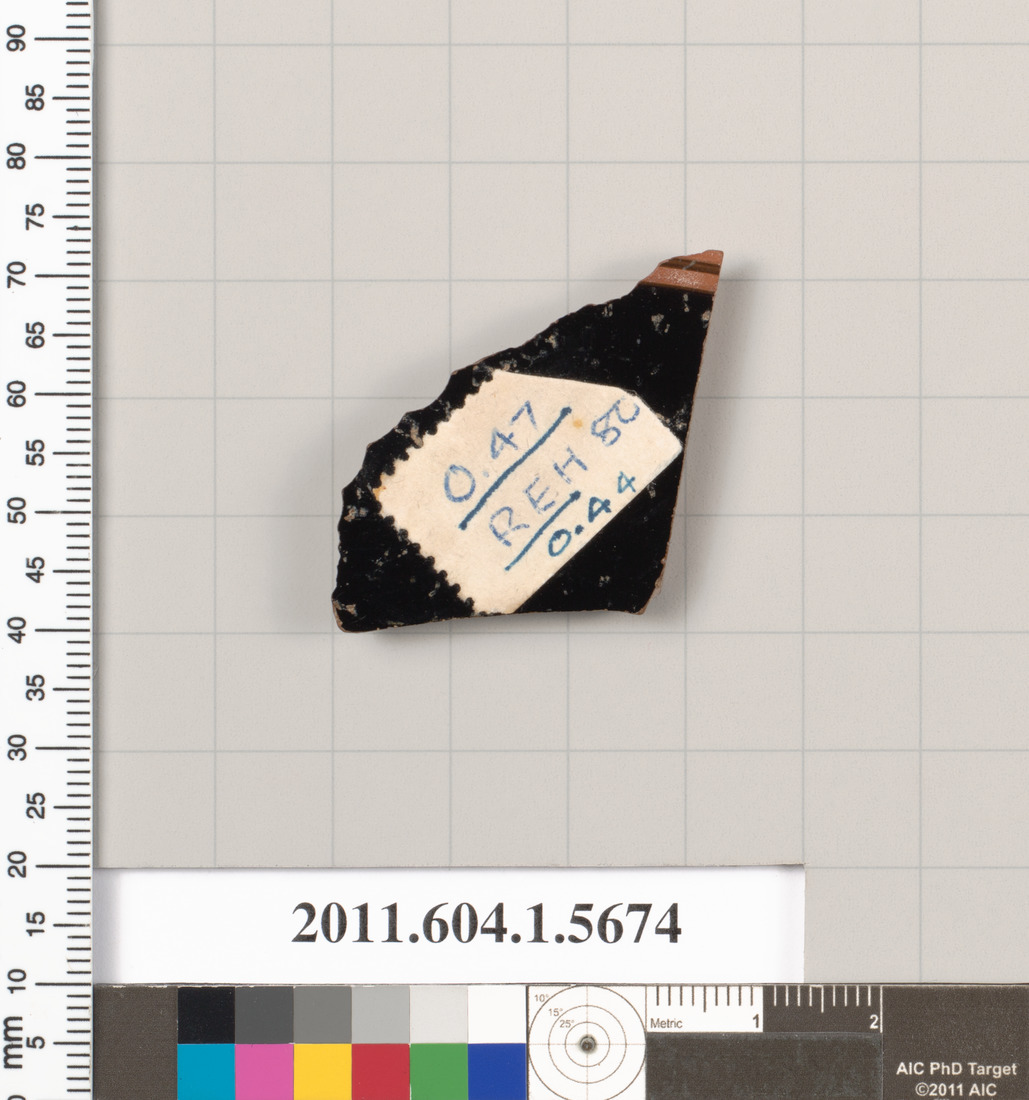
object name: kylix fragment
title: Terracotta fragment of a kylix (drinking cup)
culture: greek, attic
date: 500-480 BCE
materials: terracotta